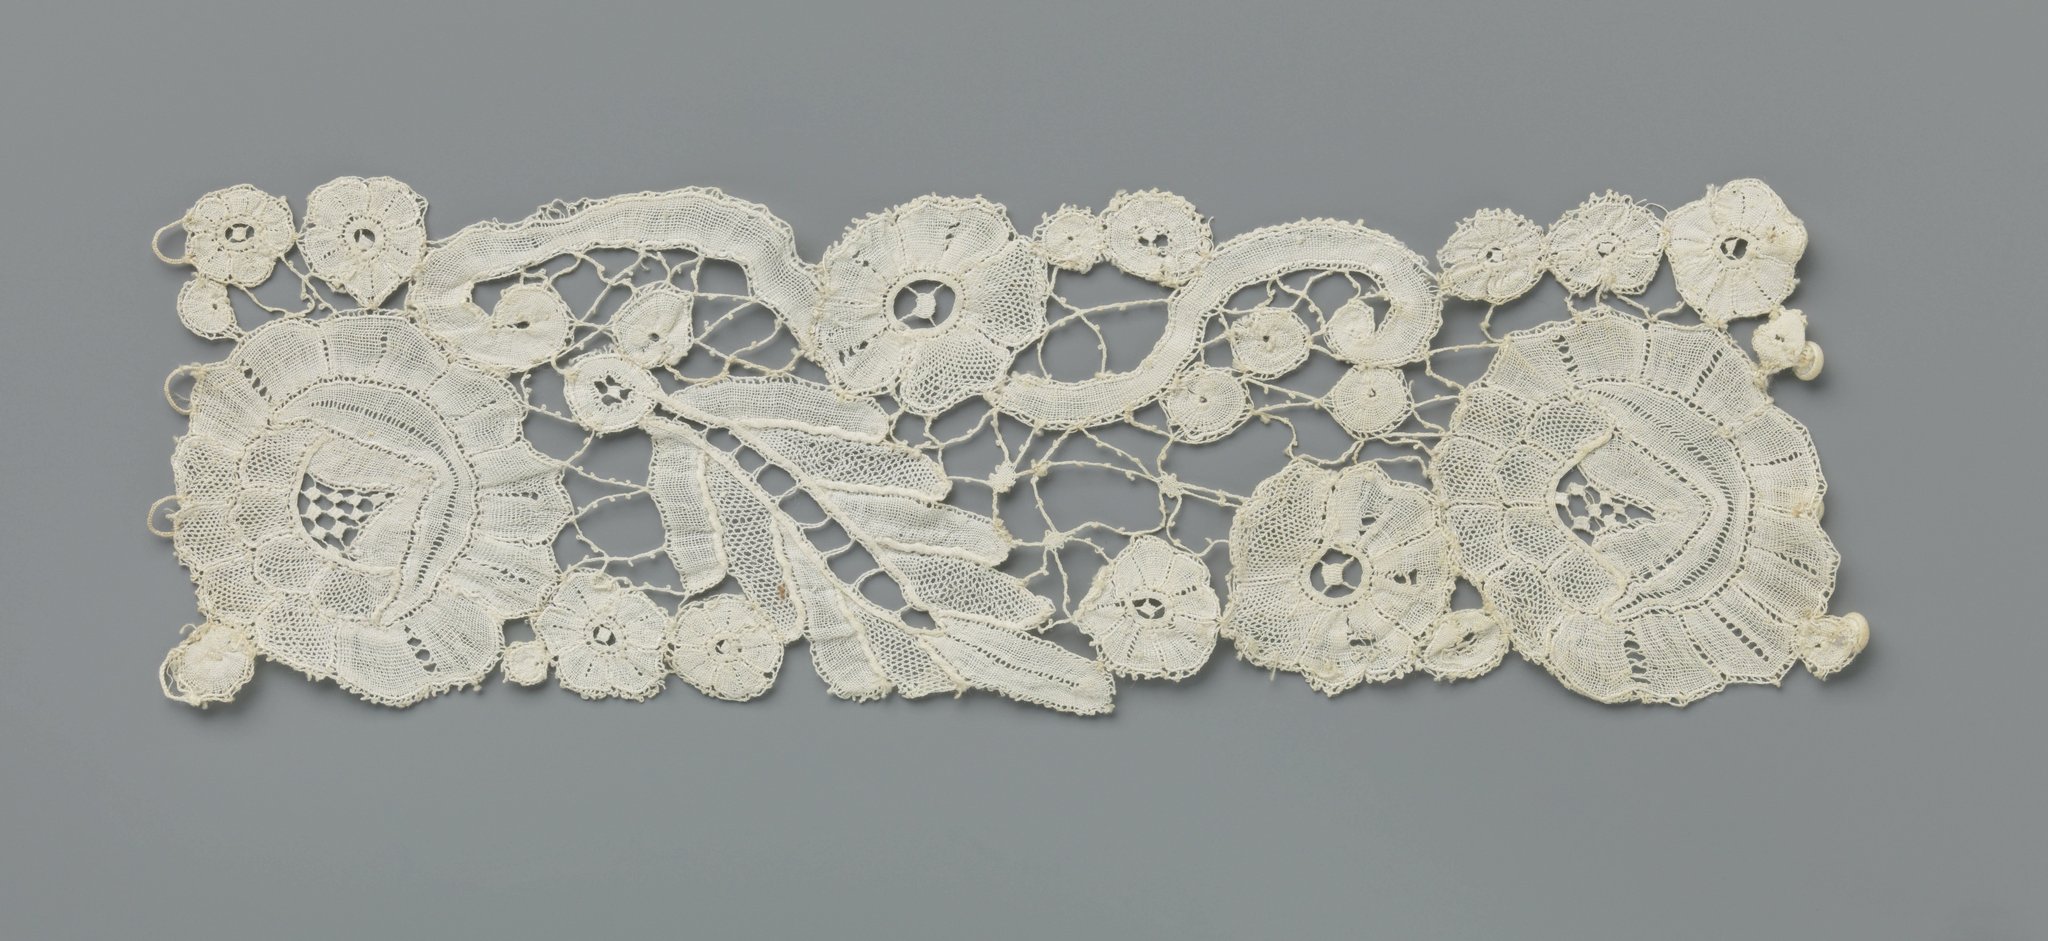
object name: cuff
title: Sierstuk voor een avondmantel van gemengde kant met rozenhaag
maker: martha berkers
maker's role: kantwerkster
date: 1915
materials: linen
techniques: lace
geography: sluis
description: Sierstuk (manchet) voor een avondmantel van naturelkleurige gemengde kant - kloskant in combinatie met naaldkant - Brusselse duchesse. Op een wijd gespreide vlechtengrond staan rozen die meestal op twee bladeren steunen. Een tussenornament bestaat uit enkele en dubbele voluutranken en vele kleine bloempjes. Met naturelkleurige stofknoopjes en knooplusjes aan de korte kanten.